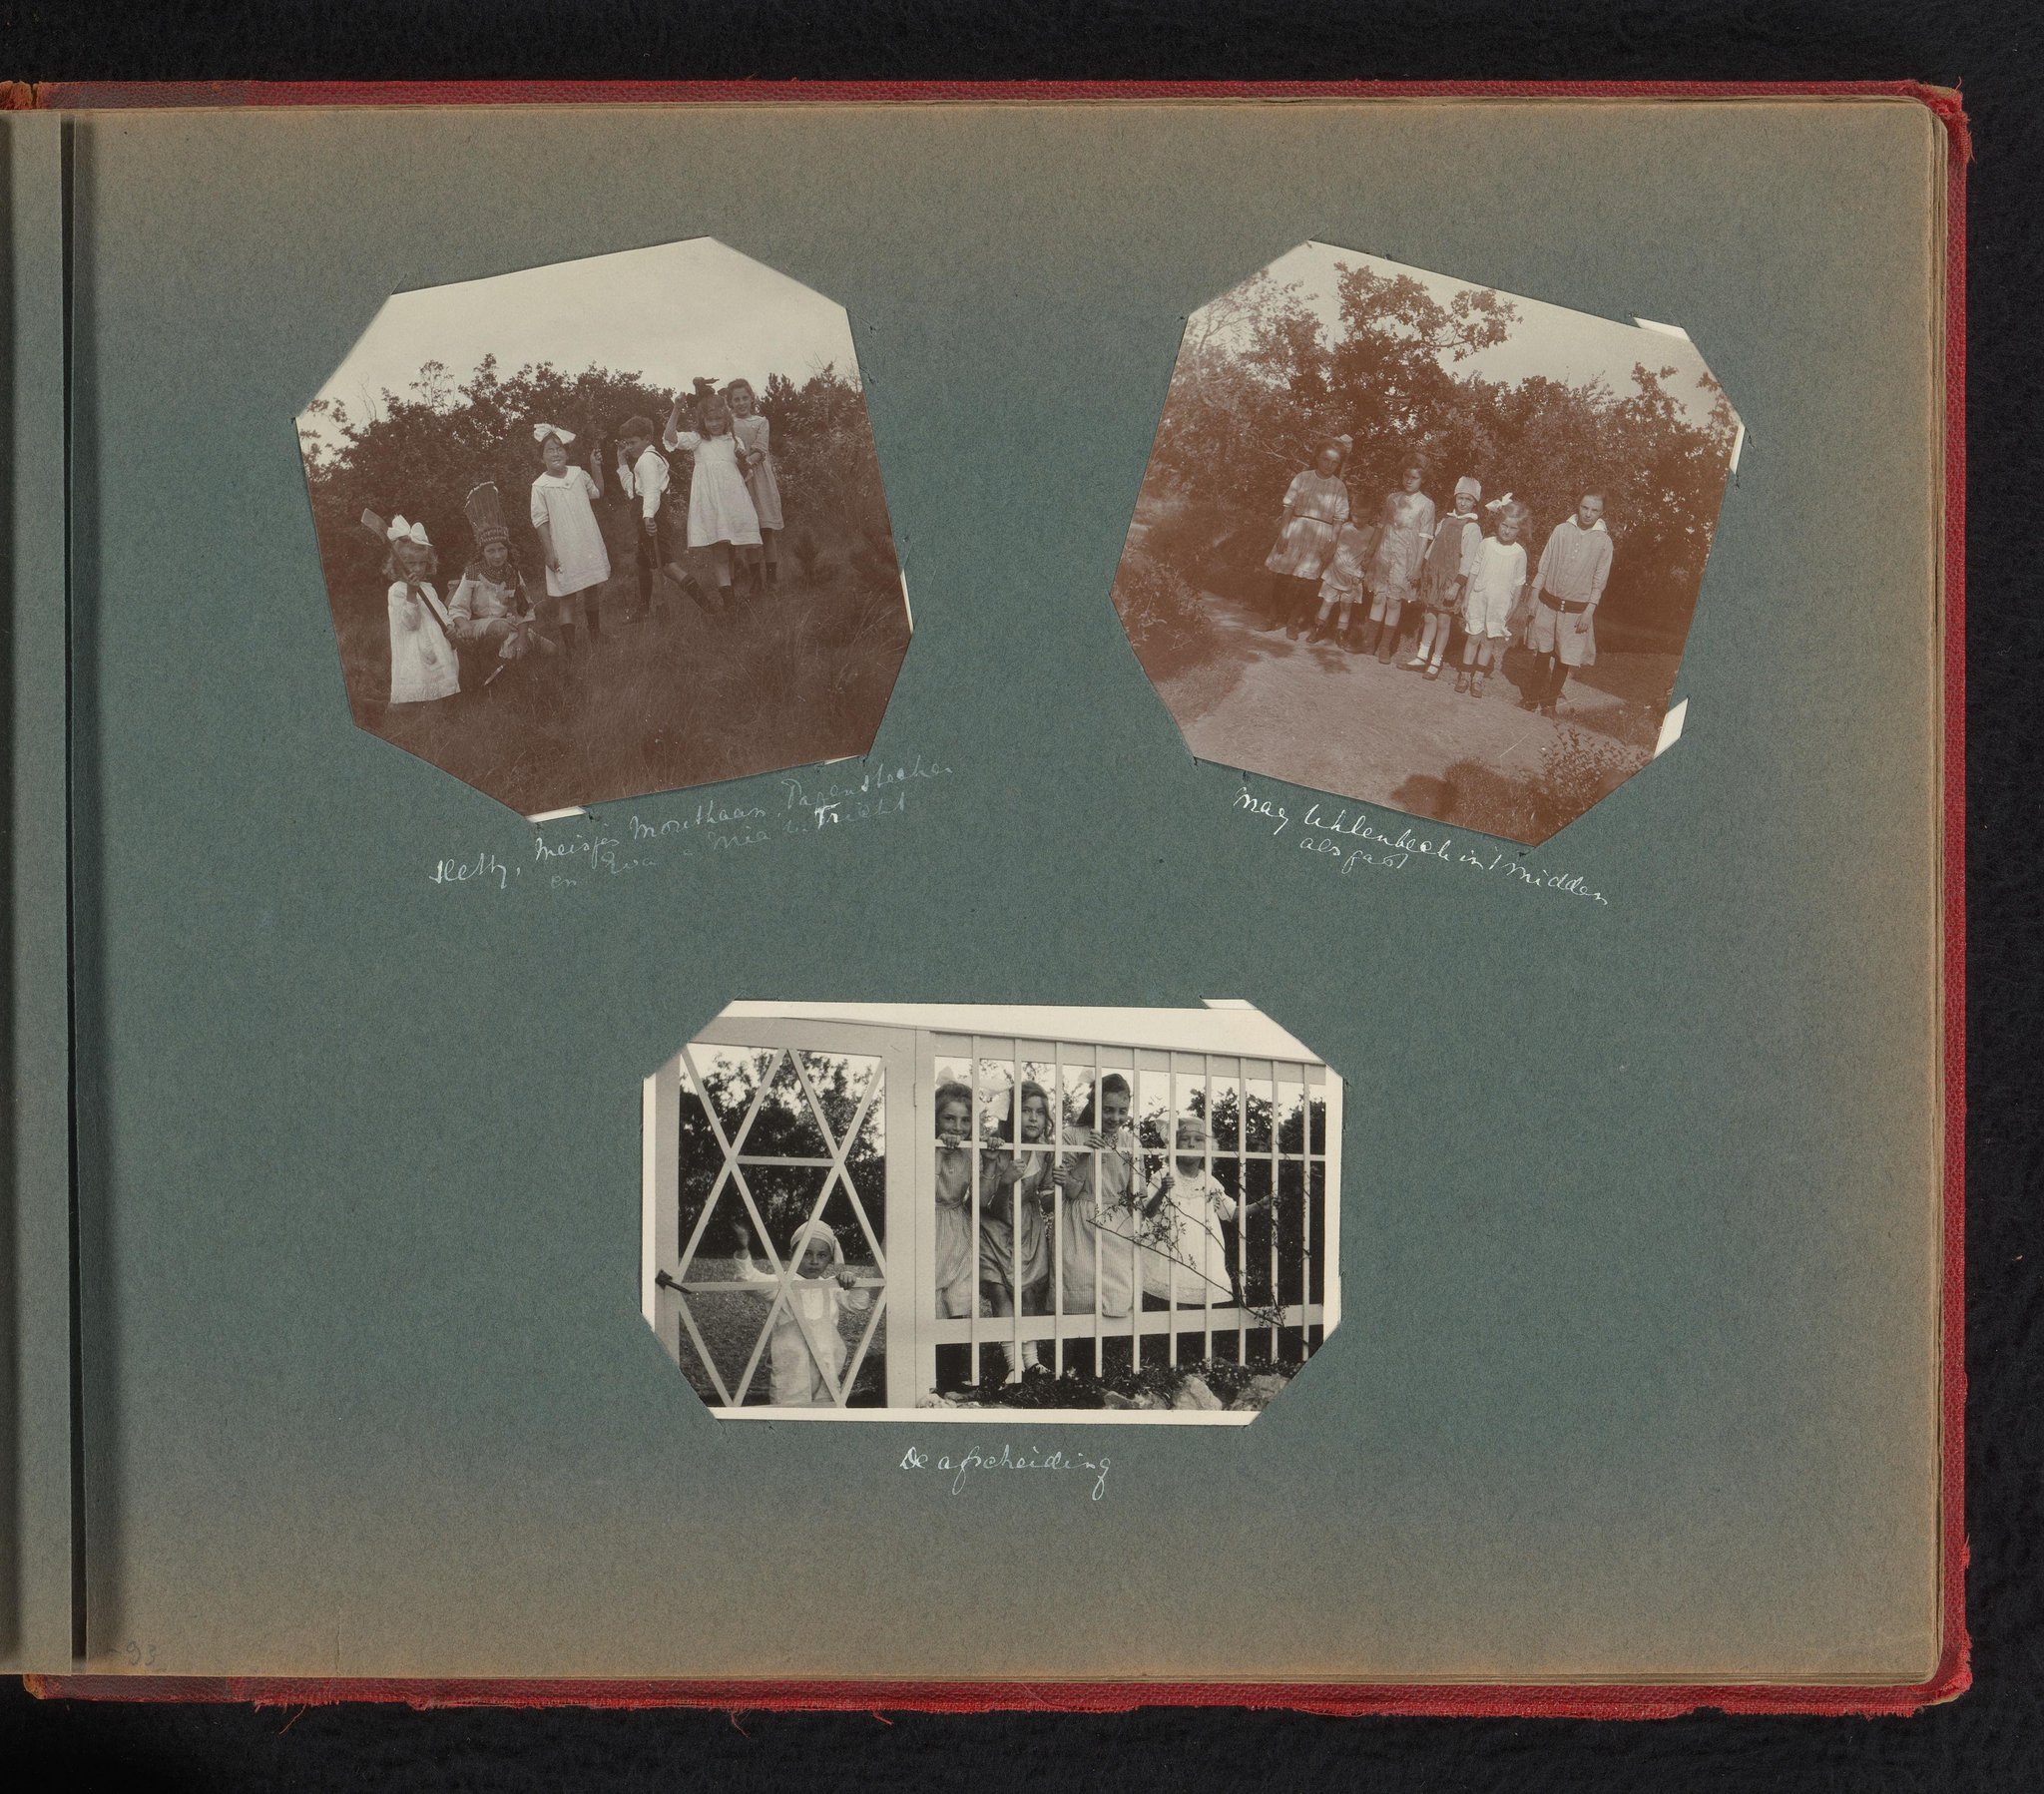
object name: photograph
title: Eva en Hetty Boelen met vrienden, waaronder Eva en Mia van Tricht en May Uhlenbeck, in een bos, mogelijk het Naaldenveld in Aerdenhout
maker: charlotte alida boelen-matthes (lot)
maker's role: amateurfotograaf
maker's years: 1889-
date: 1920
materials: paper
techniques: gelatin silver print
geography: aerdenhout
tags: eva charlotte pennink-boelen, forest, wood, child and nature (games and plays)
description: Deze foto's zijn onderdeel van een album.